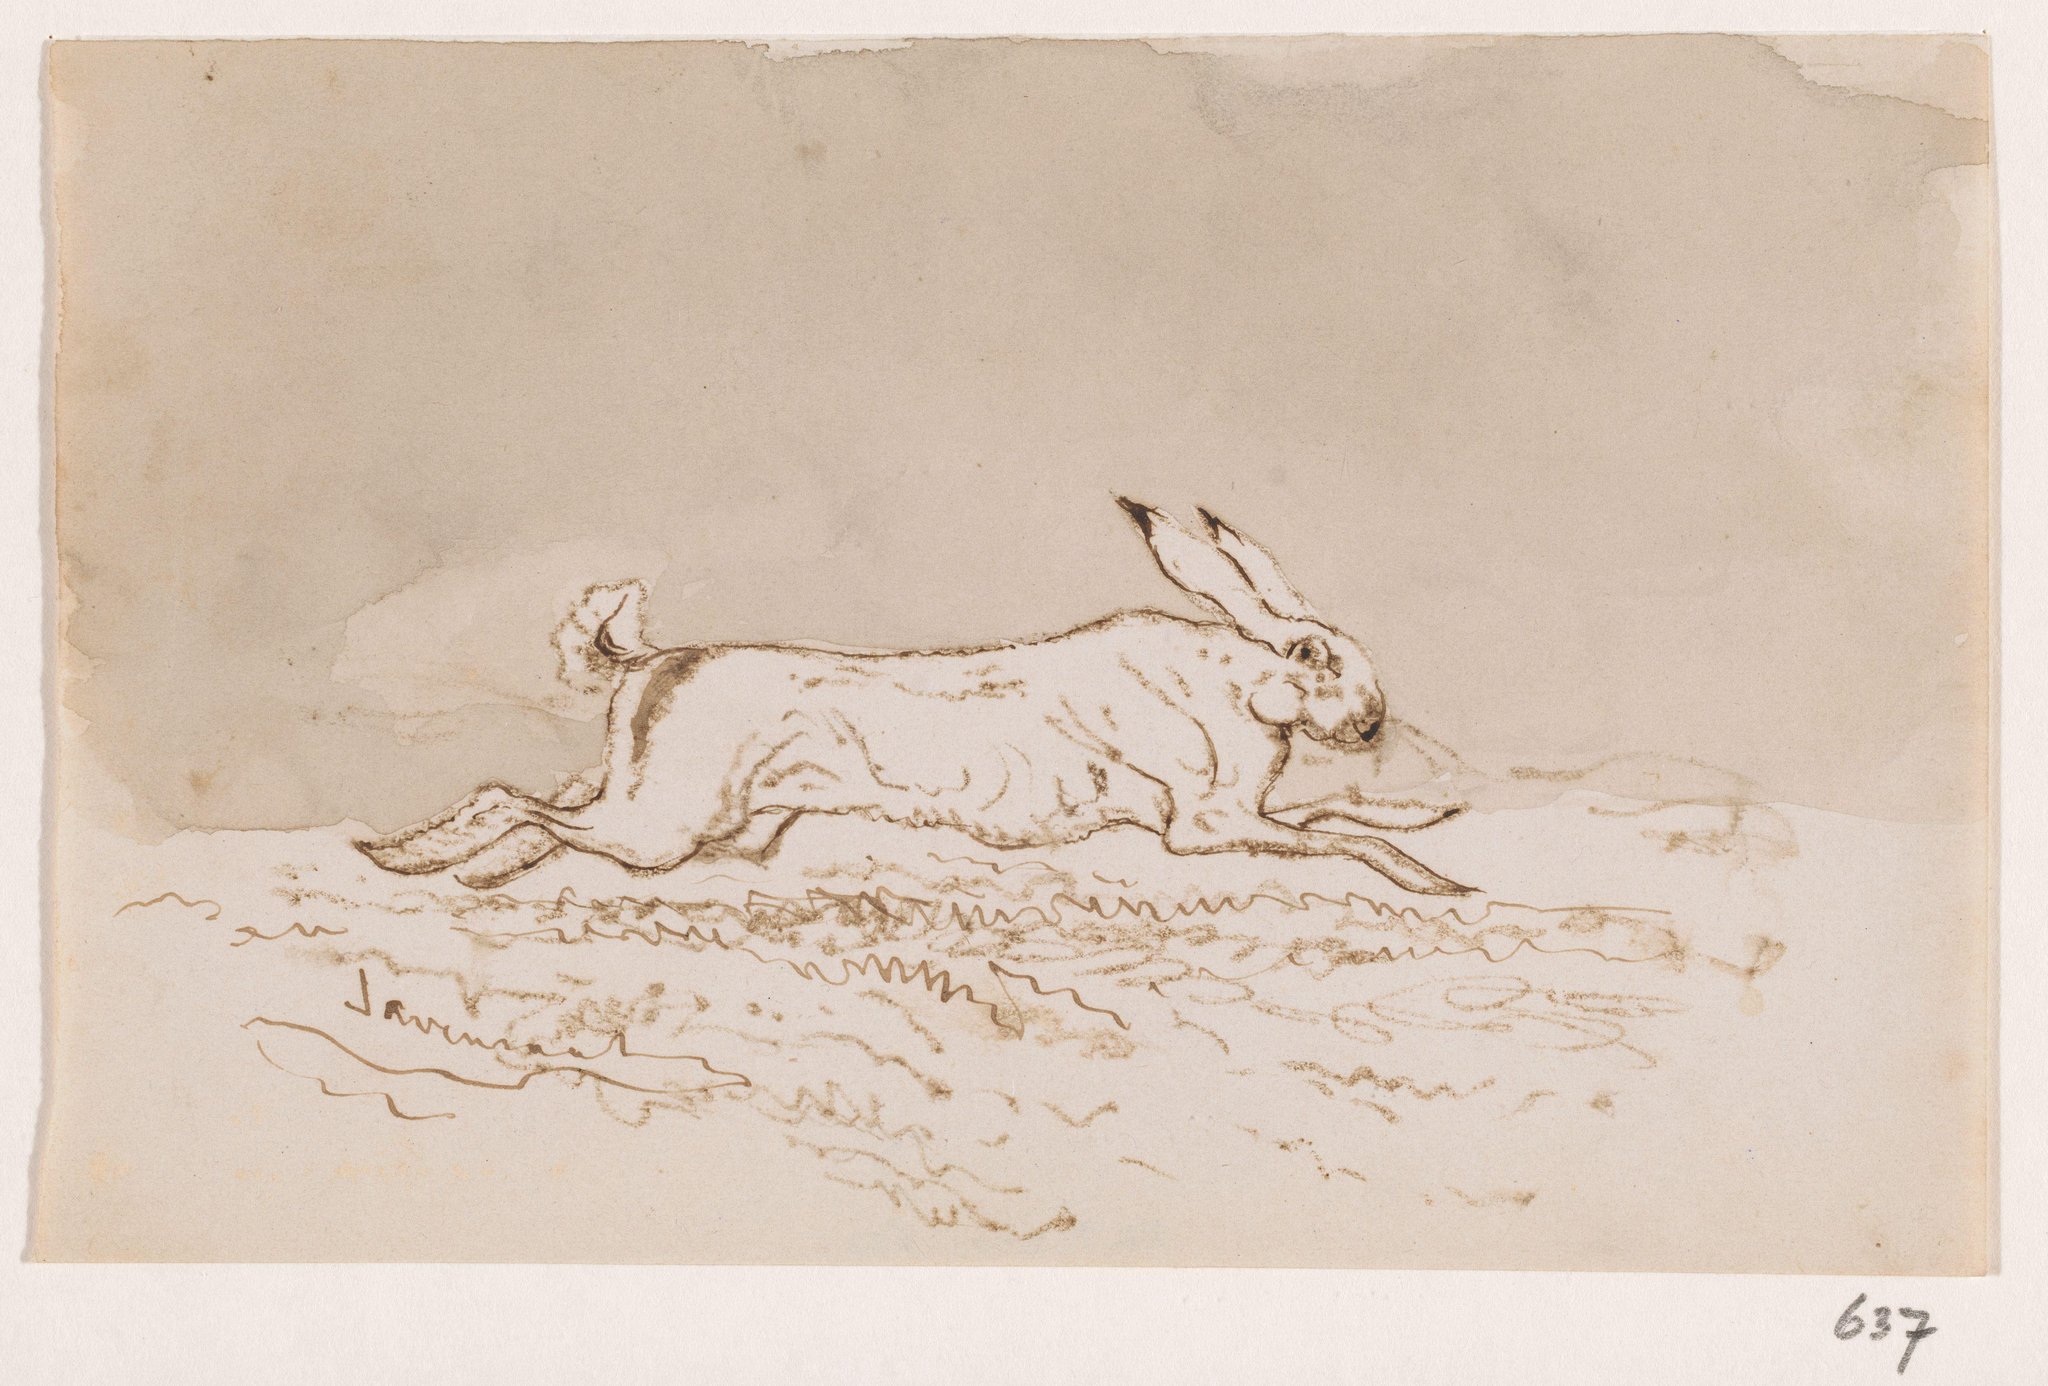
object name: drawing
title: Haas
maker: johannes tavenraat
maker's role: draughtsman, painter, print maker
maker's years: 1809-1881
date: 1840-1880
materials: ink, paper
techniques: brush, pen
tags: rodents: hare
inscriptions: signature: ‘Tavenraat’, collector's mark: Lugt 2228